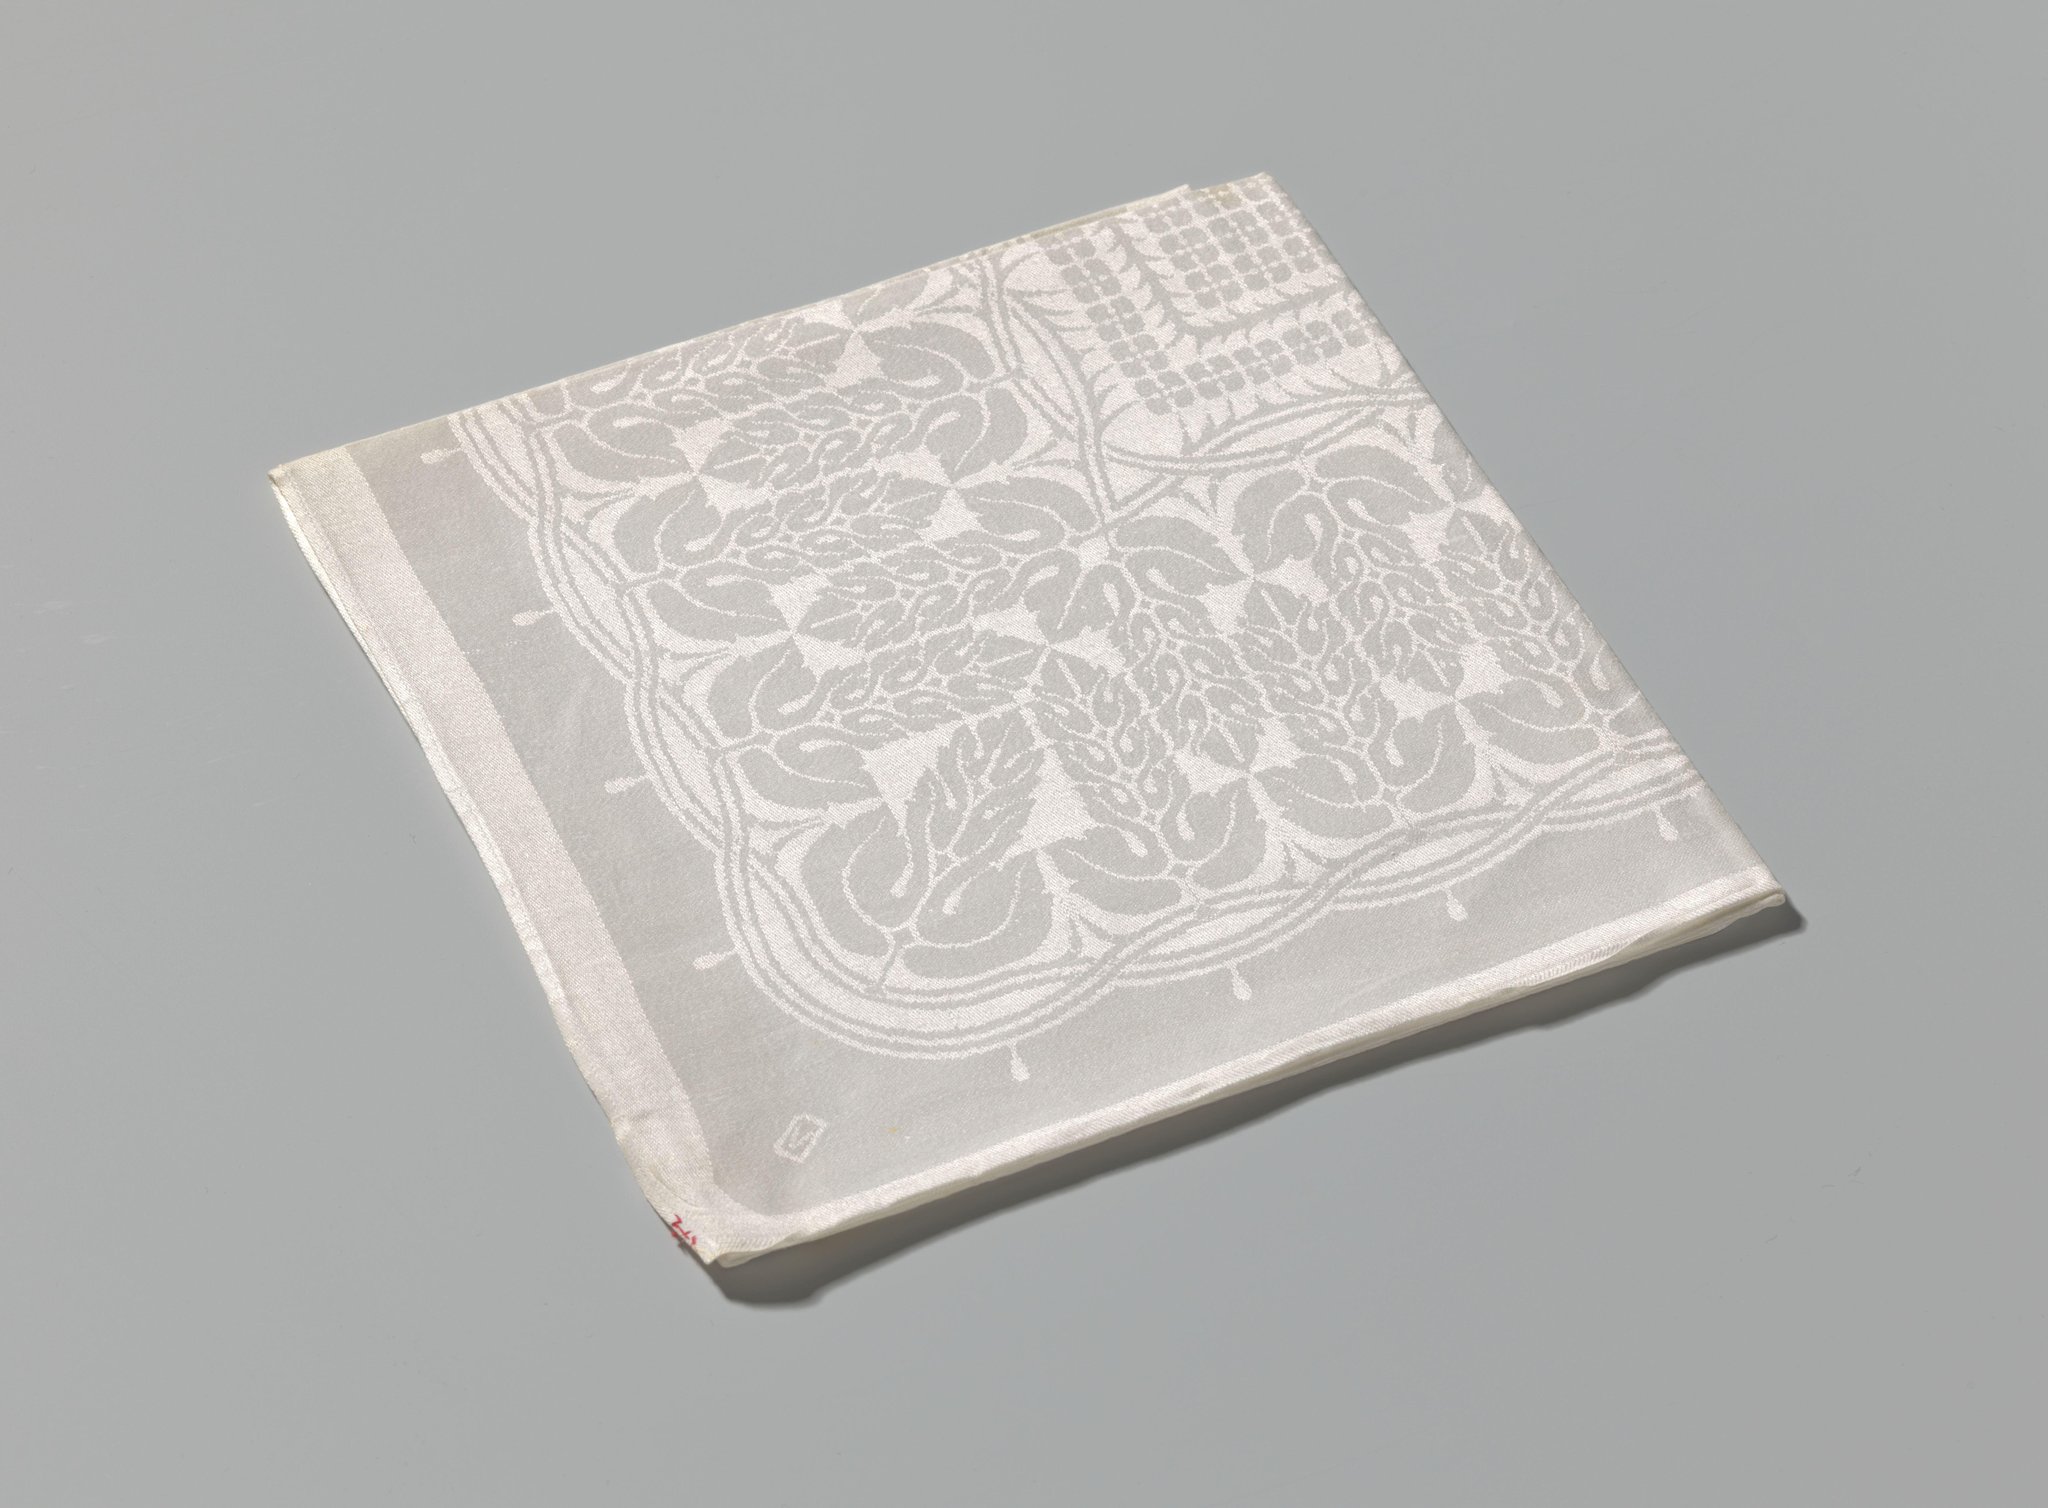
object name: napkin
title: Servet van linnendamast met meidoorns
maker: chris lebeau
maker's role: draughtsman, print maker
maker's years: 1878-1945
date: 1900-1925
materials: linen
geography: eindhoven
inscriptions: mark: ‘TZ’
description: Wit linnen damasten servet met een dessin van meidoorns.